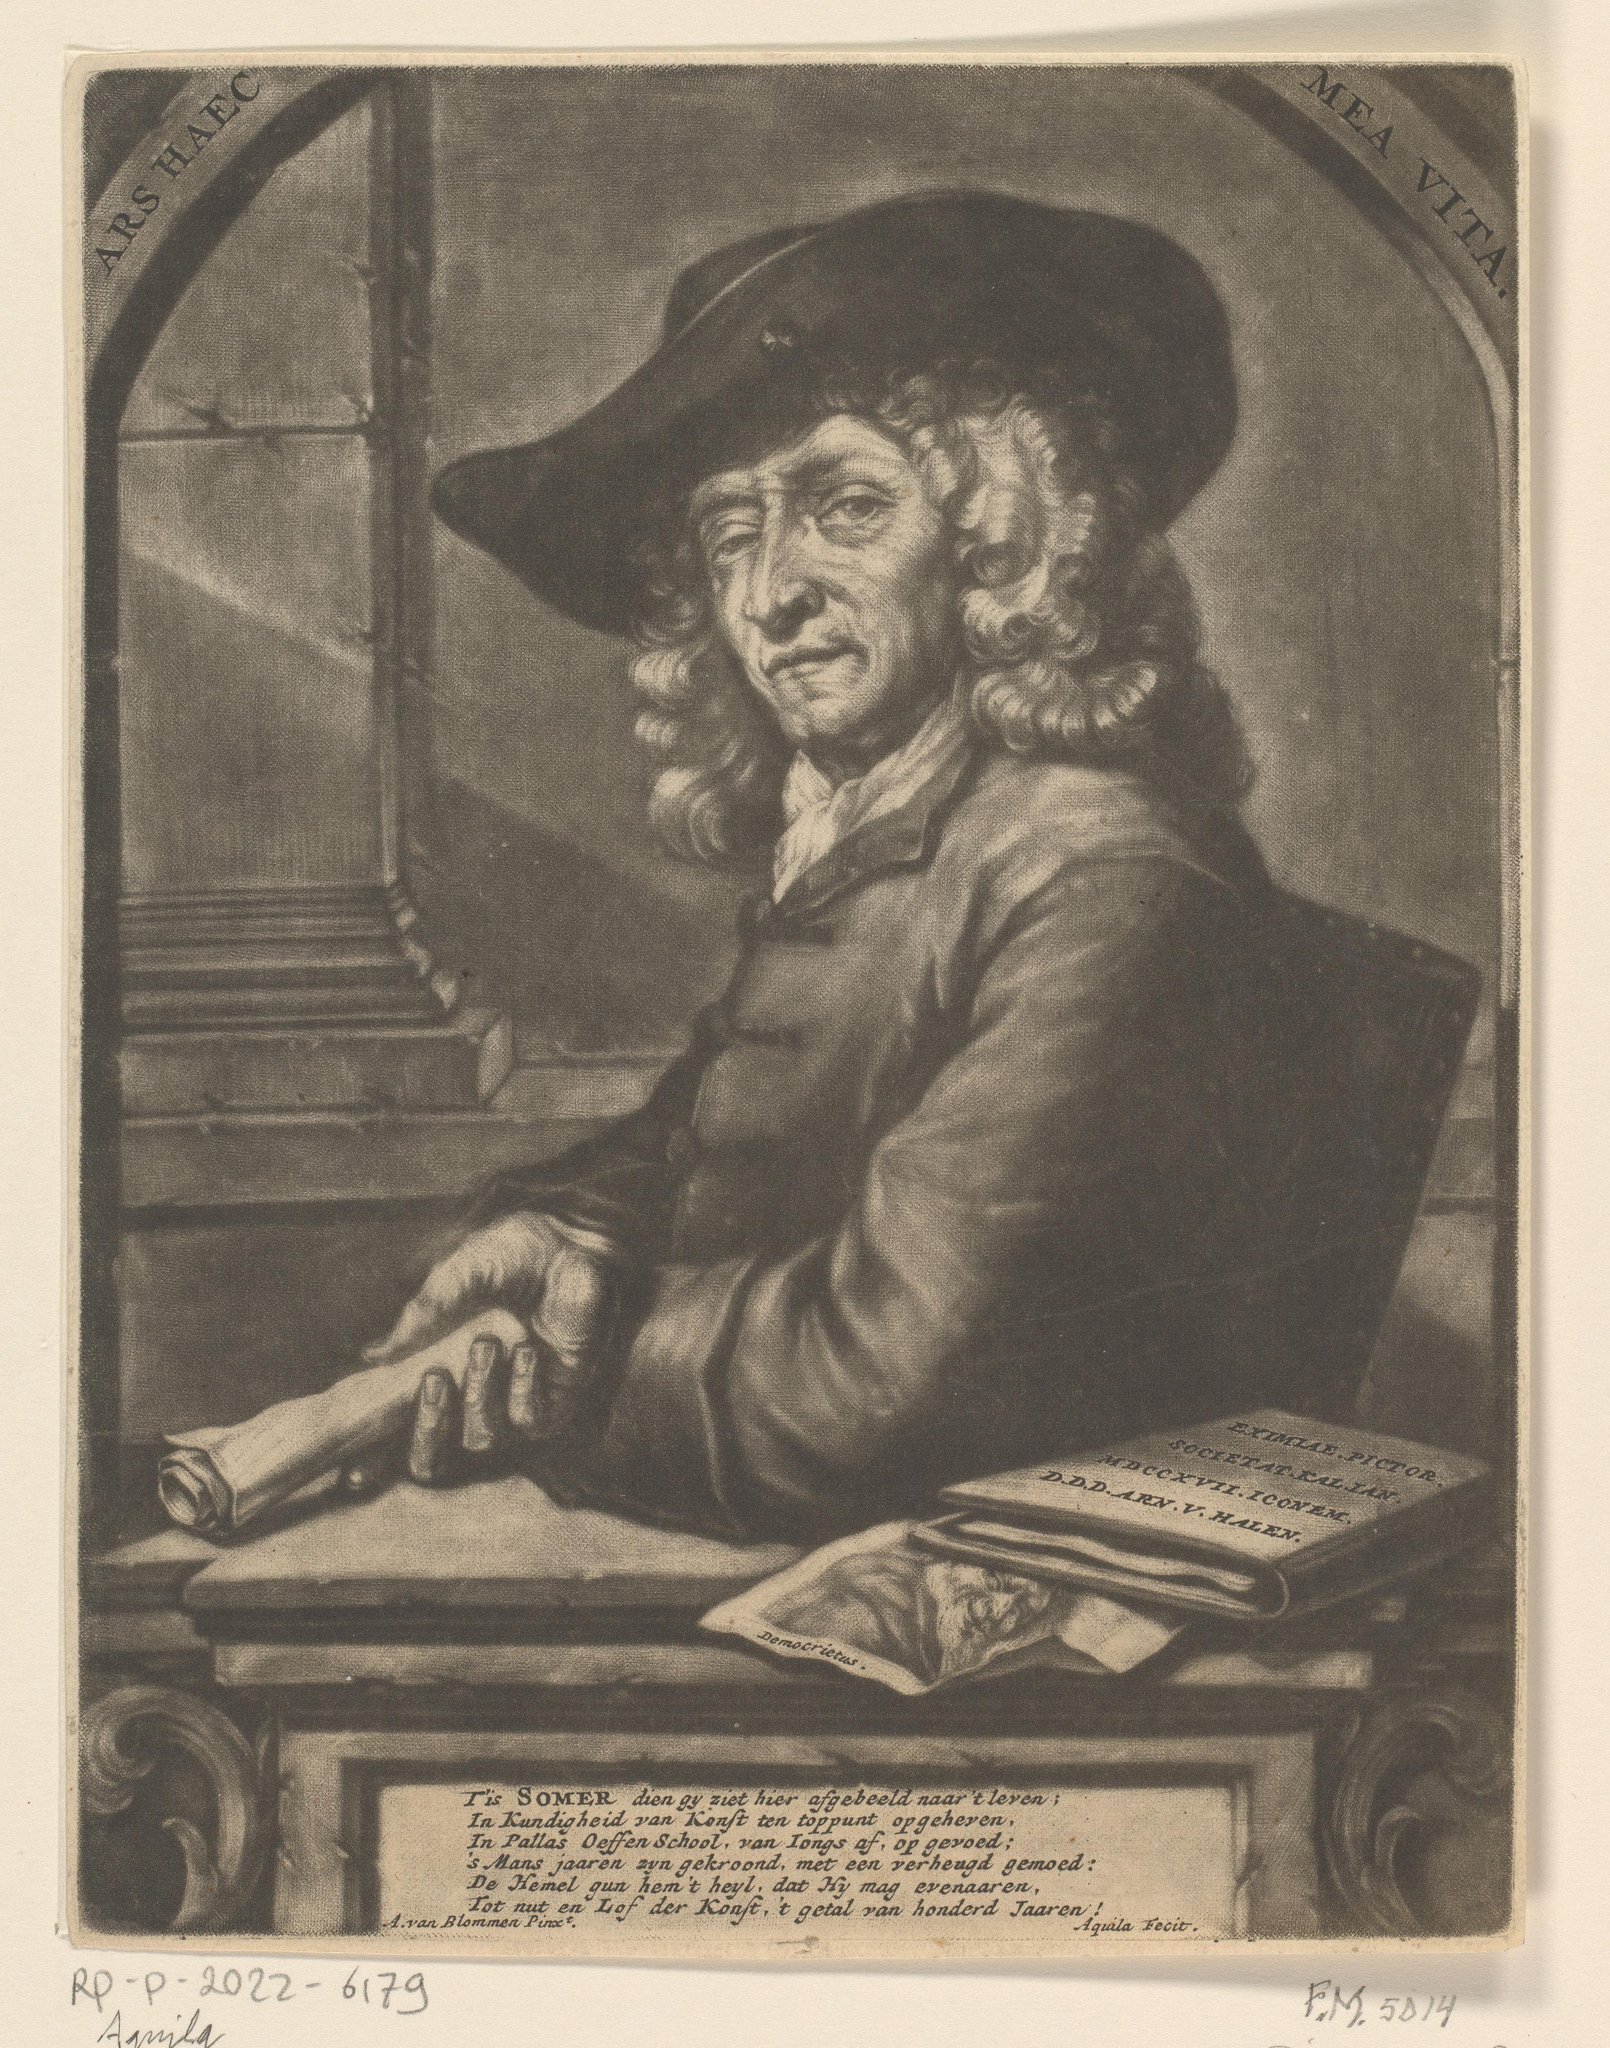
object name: titelblad, titelpagina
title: Titelpagina voor: Zollikofer, Johannes. Neueröffneter Weyhrauch-Schatz (...) S.l., s.n., 1691-1861.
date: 1717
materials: paper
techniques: engraving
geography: amsterdam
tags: draughtsman, jan pietersz. zomer, print, e.g.: engraving, etching, lithograph, historical persons, art dealer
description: Waarschijnlijk het titelblad van één van de uitgaves van: Zollikofer, Johannes. Neueröffneter Weyhrauch-Schatz (...) S.l.s.n., 1691-1861.